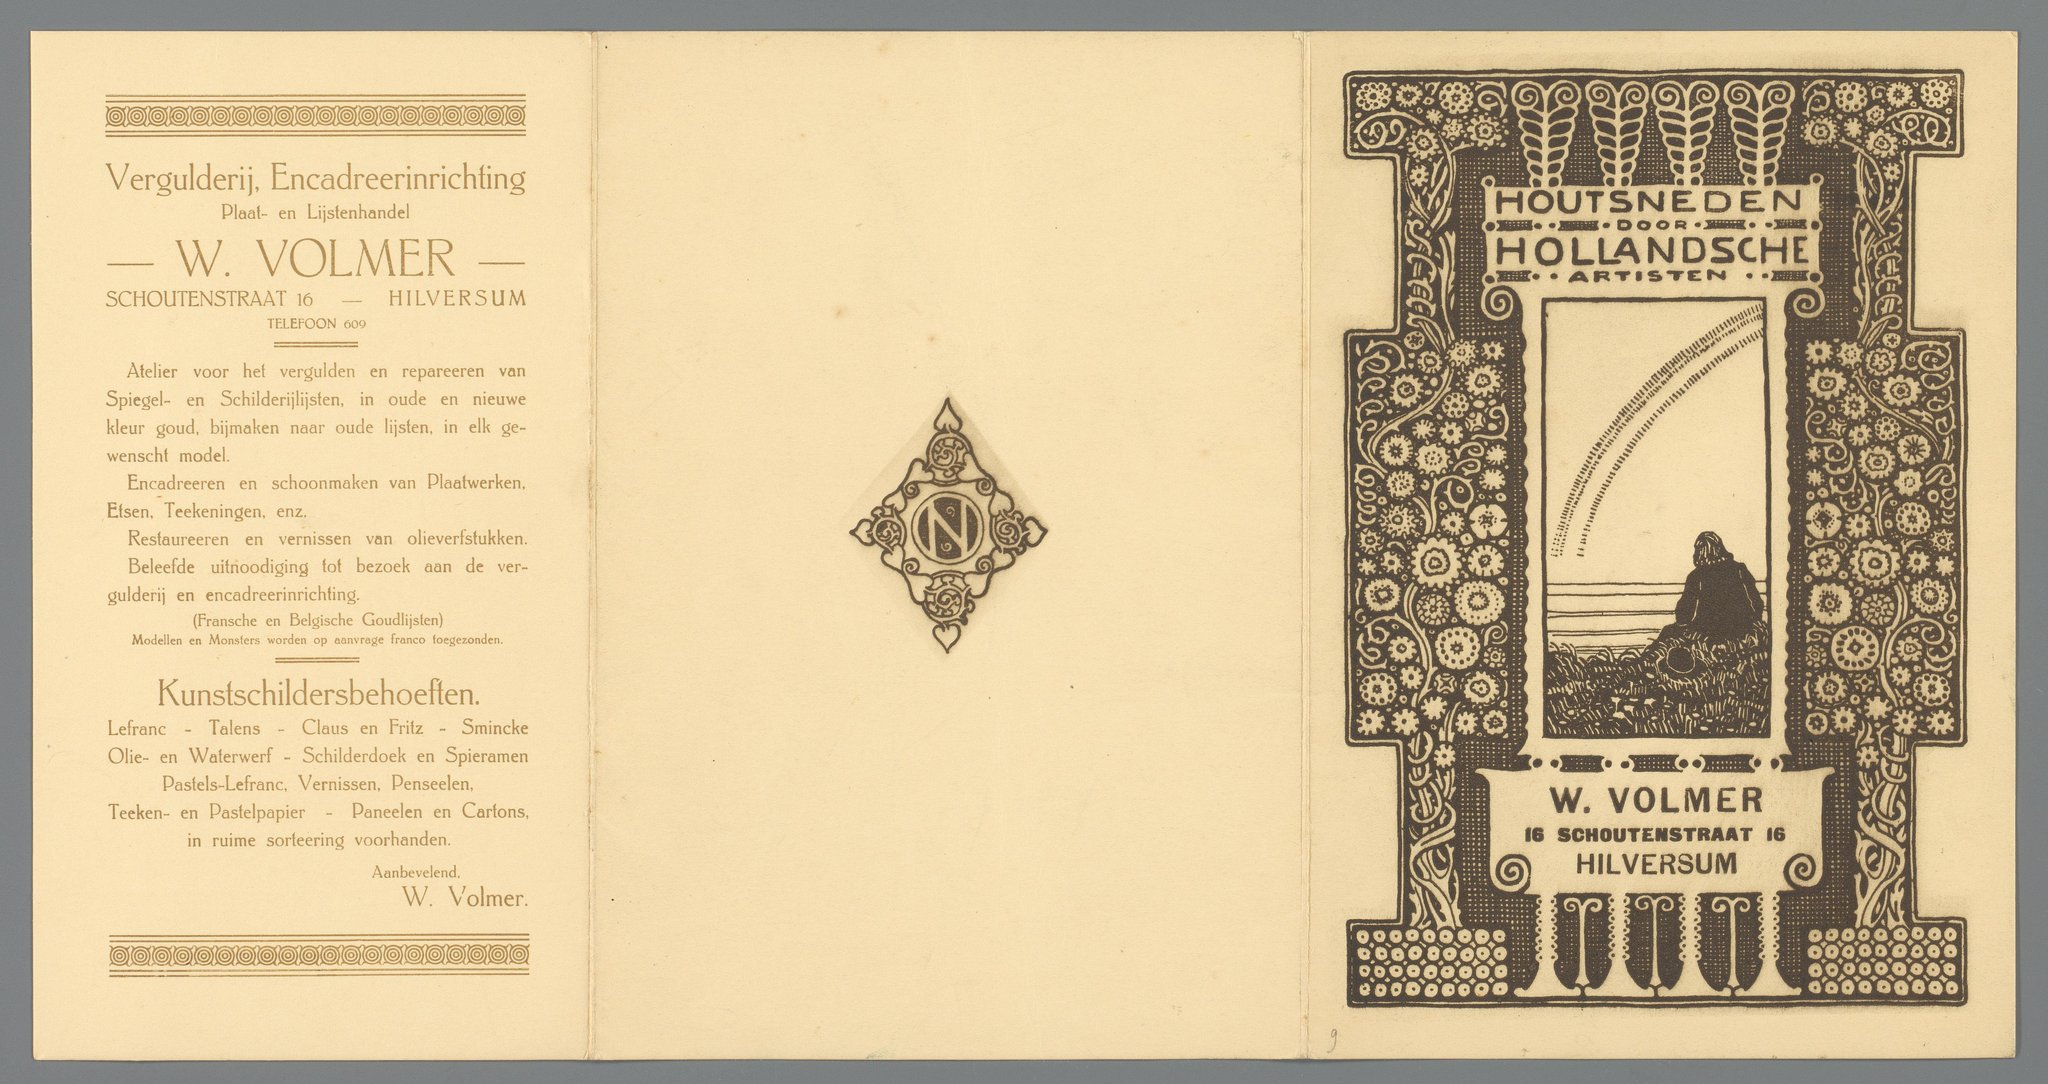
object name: print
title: Reclamefolder voor de verkoopexpositie 'Houtsneden door Hollandsche artisten' bij Kunsthandel W. Volmer in Hilversum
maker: Anonymous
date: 1900-1940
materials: paper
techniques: letterpress printing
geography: netherlands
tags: harbour, merchant shipping, shipping trade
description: Reclamefolder voor de verkoopexpositie 'Houtsneden door Hollandsche artisten' bij Kunsthandel W. Volmer in Hilversum. Omslag met zes originele houtsneden. Titel en naam binnen ornamentele omlijsting, centraal een op de grond zittende figuur met regenboog. Ruitvormig vignet met de letter N op de achterzijde. Binnenflap met reclame voor de producten van W. Volmer.